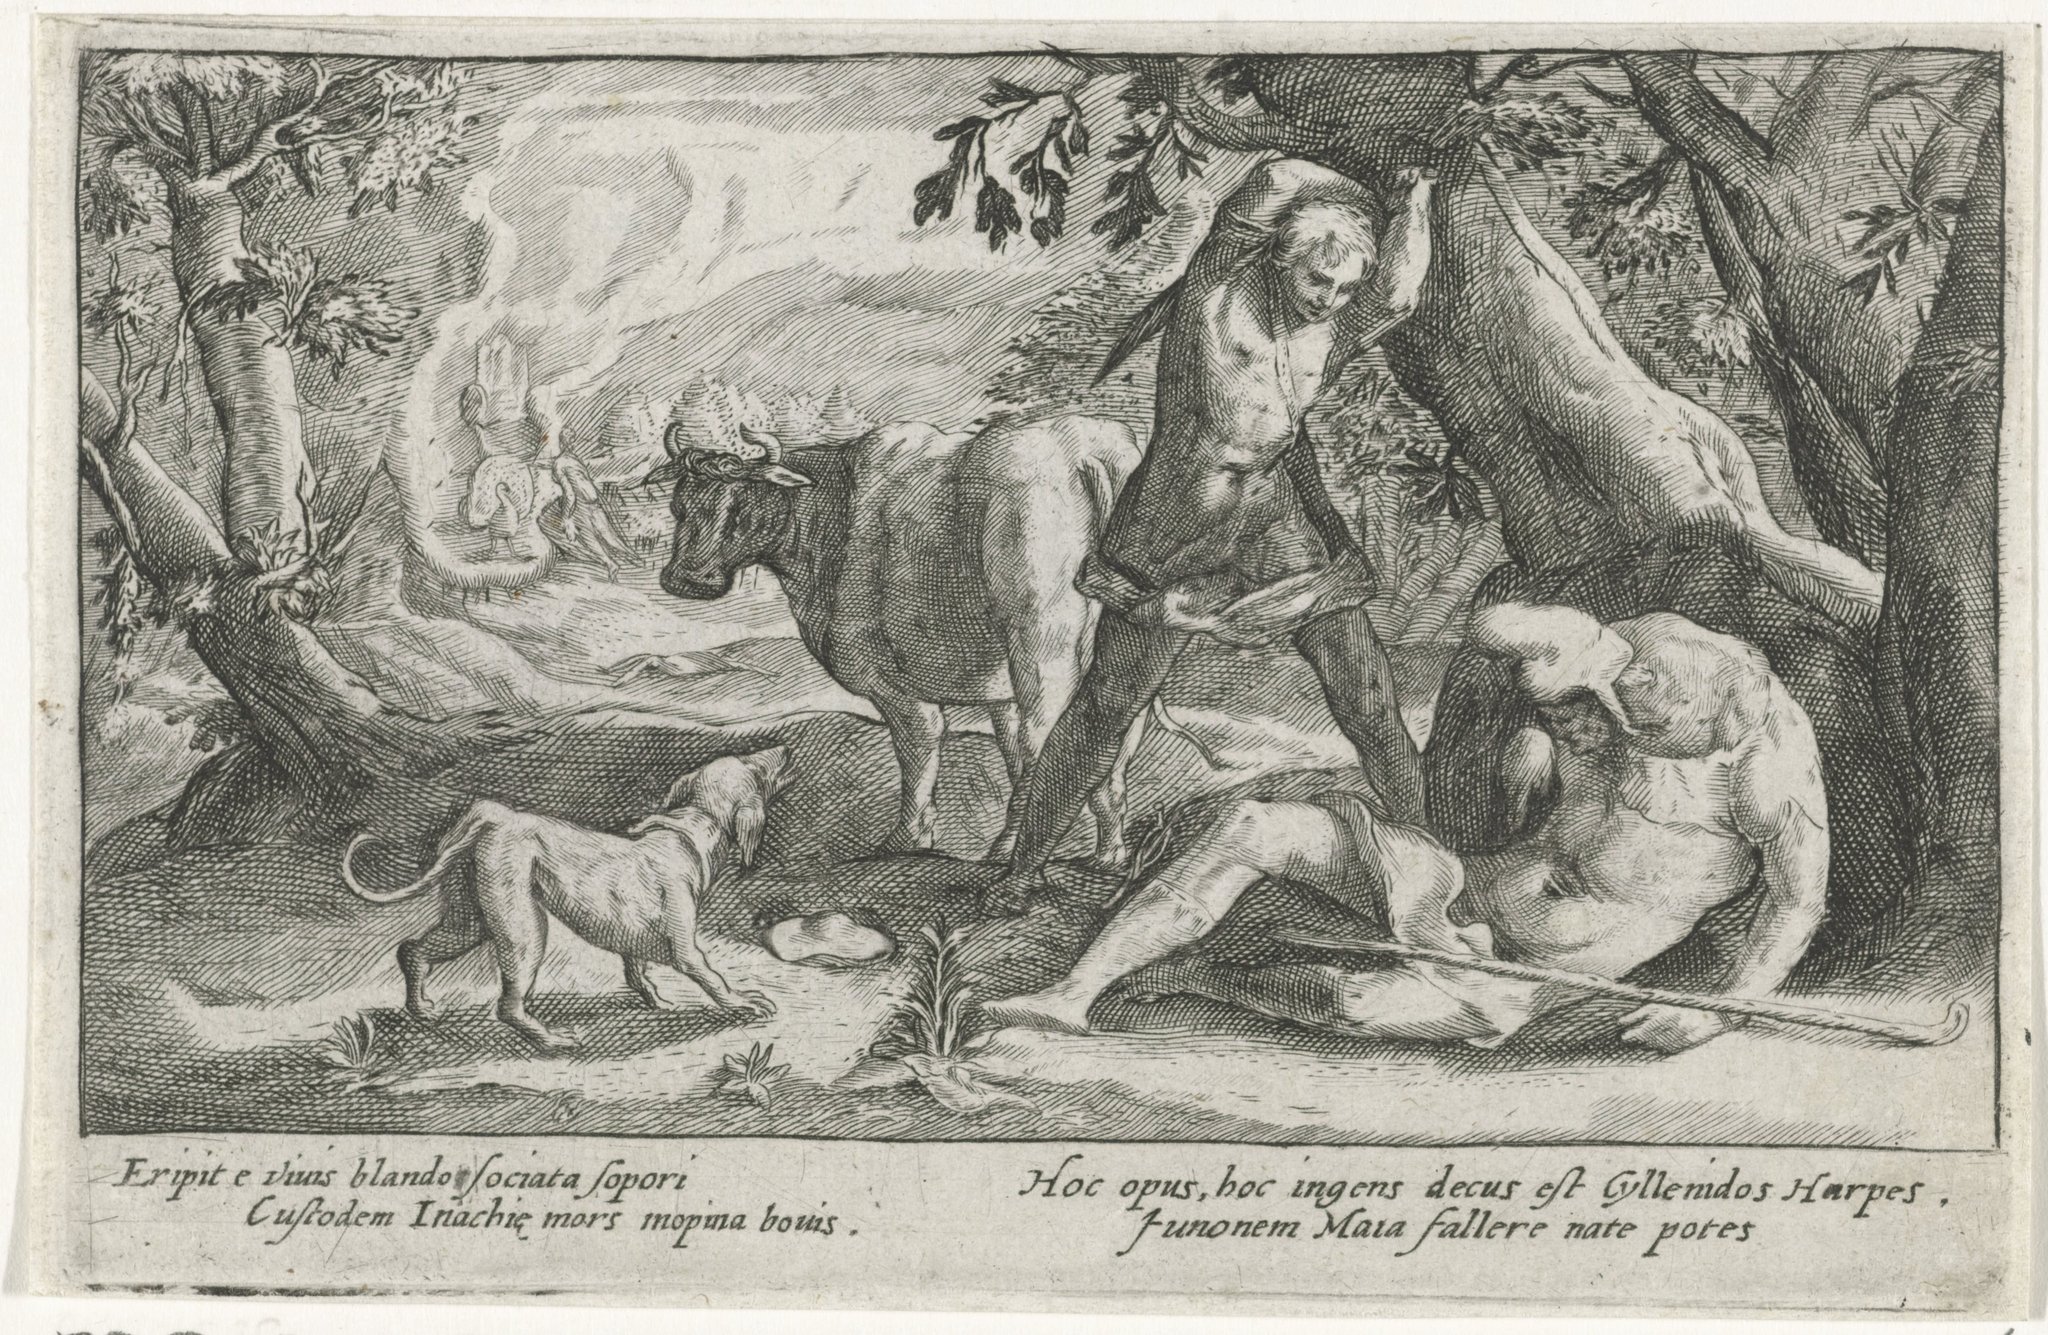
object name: print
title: Mercurius doodt Argus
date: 1602-1607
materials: paper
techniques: engraving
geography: cologne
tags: mercury beheads argus, argus' eyes changed into peacock's 'eyes' (ocelli): juno sets argus' eyes on her peacock, after argus, while watching io, has been slain by mercury (ovid, metamorphoses i 723)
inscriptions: collector's mark: Lugt 2228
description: Mercurius slaat met zijn zwaard het hoofd van Argus af. Links op de achtergrond zet Juno de ogen van Argus in de staart van haar pauw. In de marge een vierregelig onderschrift, in twee kolommen, in het Latijn.